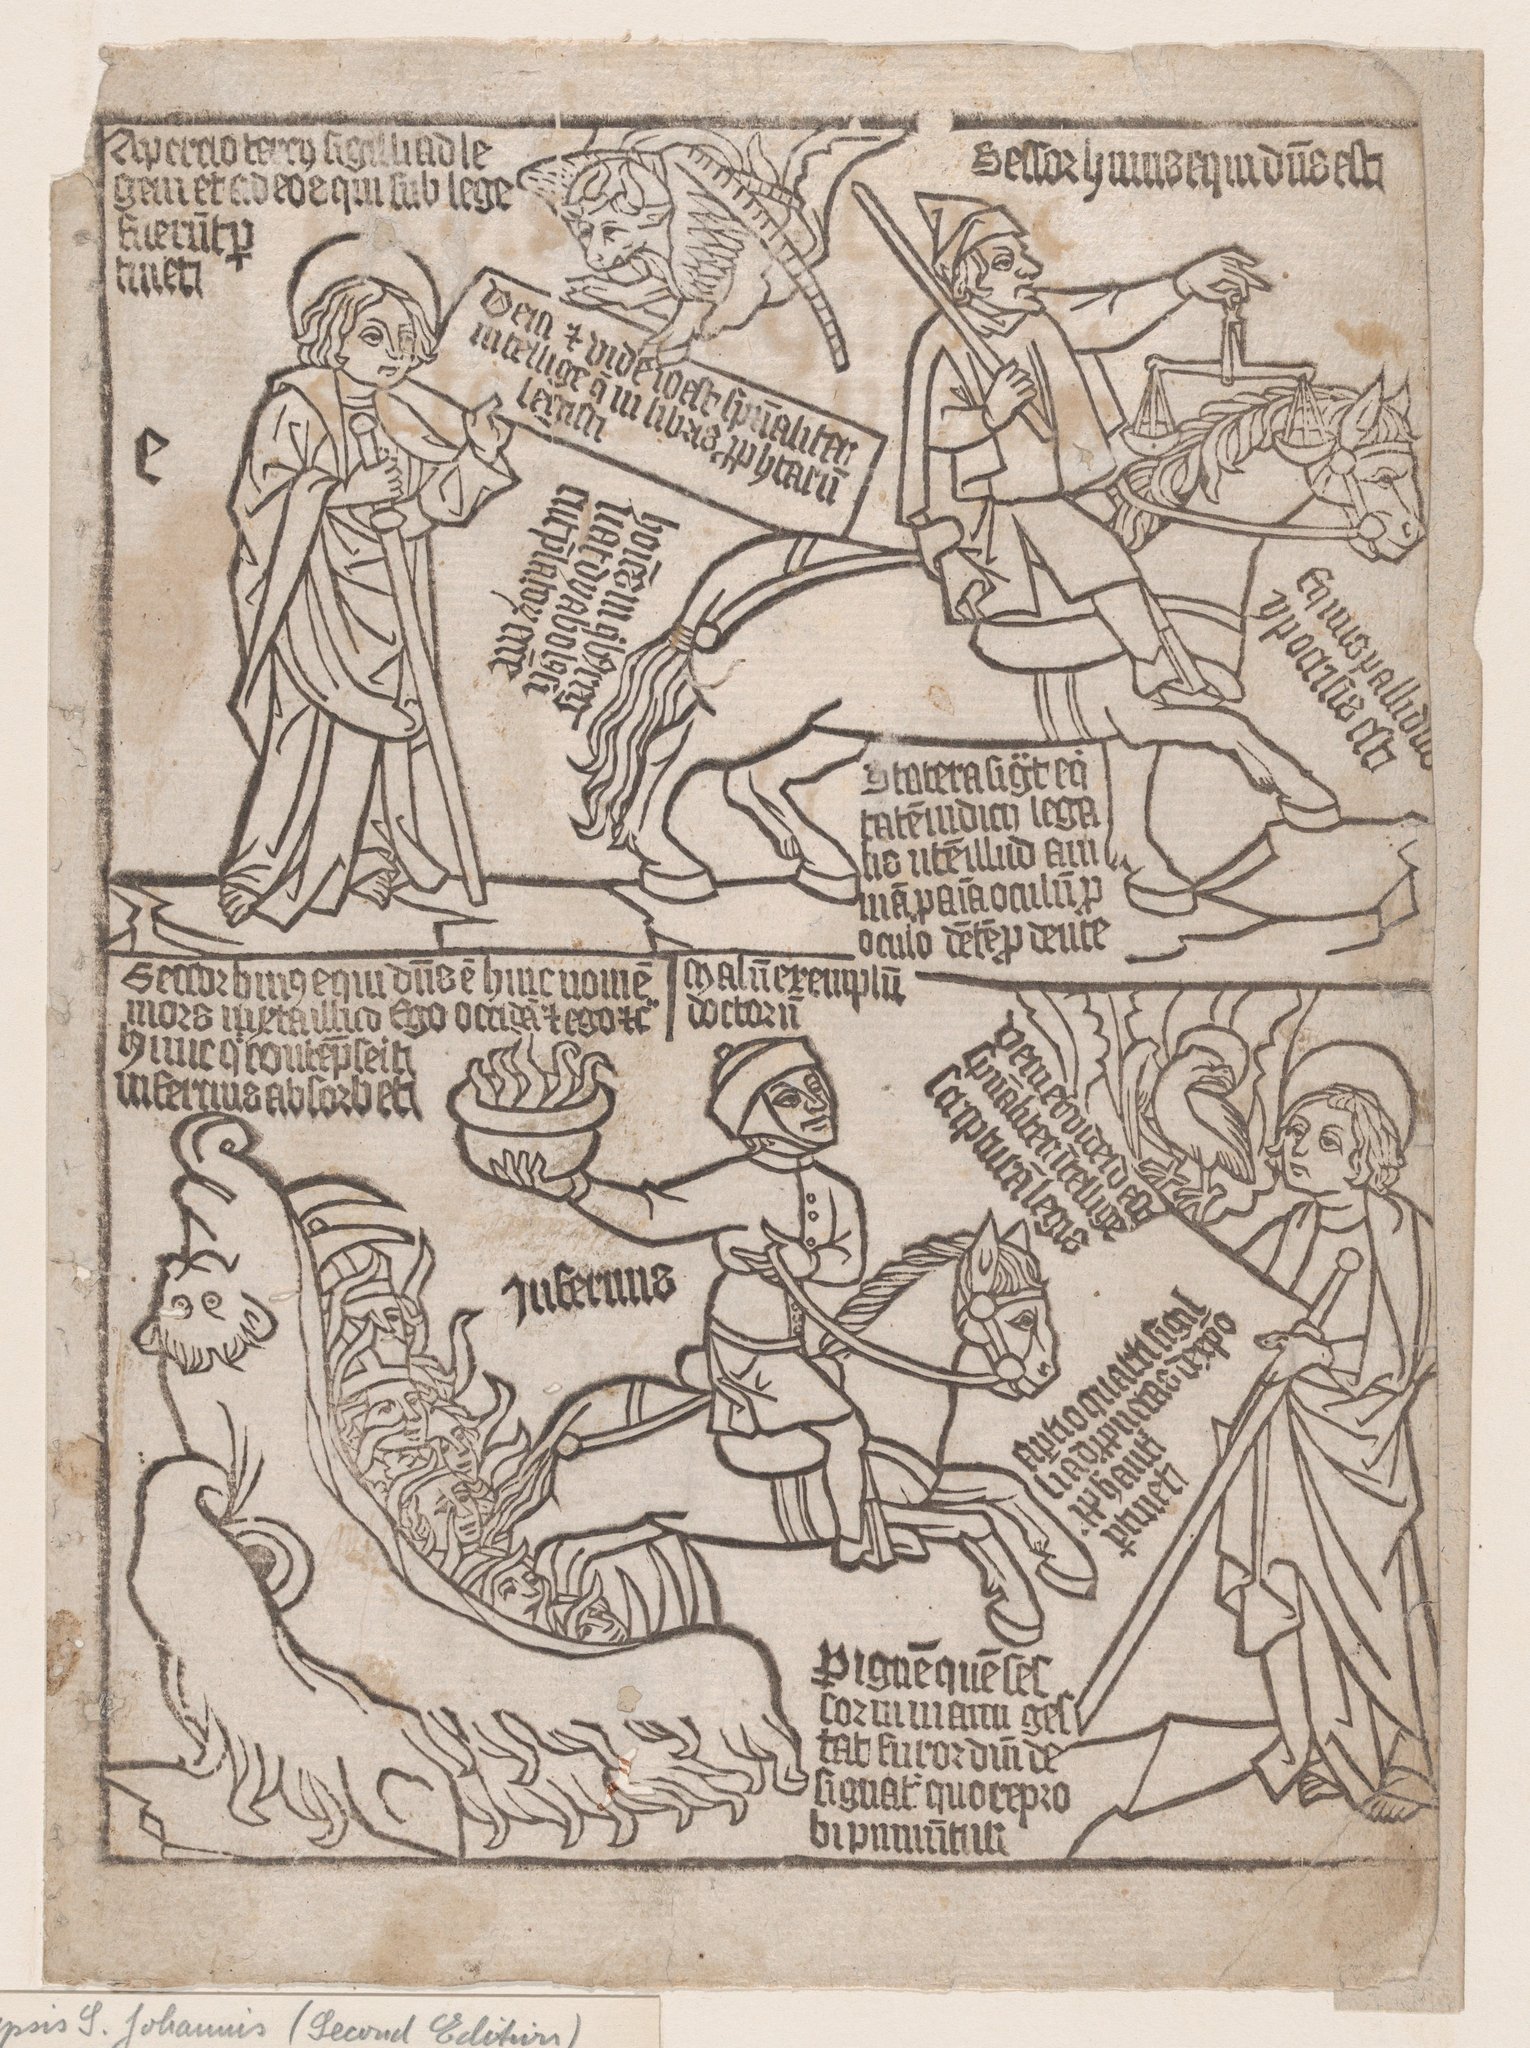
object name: print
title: A Rider on a Black Horse with a Pair of Balances in His Hand; and A Pale Horse with Death as Its Rider, from an Apocalypse blockbook, 2nd edition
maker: anonymous, netherlandish, 15th century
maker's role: artist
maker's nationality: netherlandish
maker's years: 1400-1500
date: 1440-1450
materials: ink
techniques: printing, woodcut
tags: horses,apocalypse